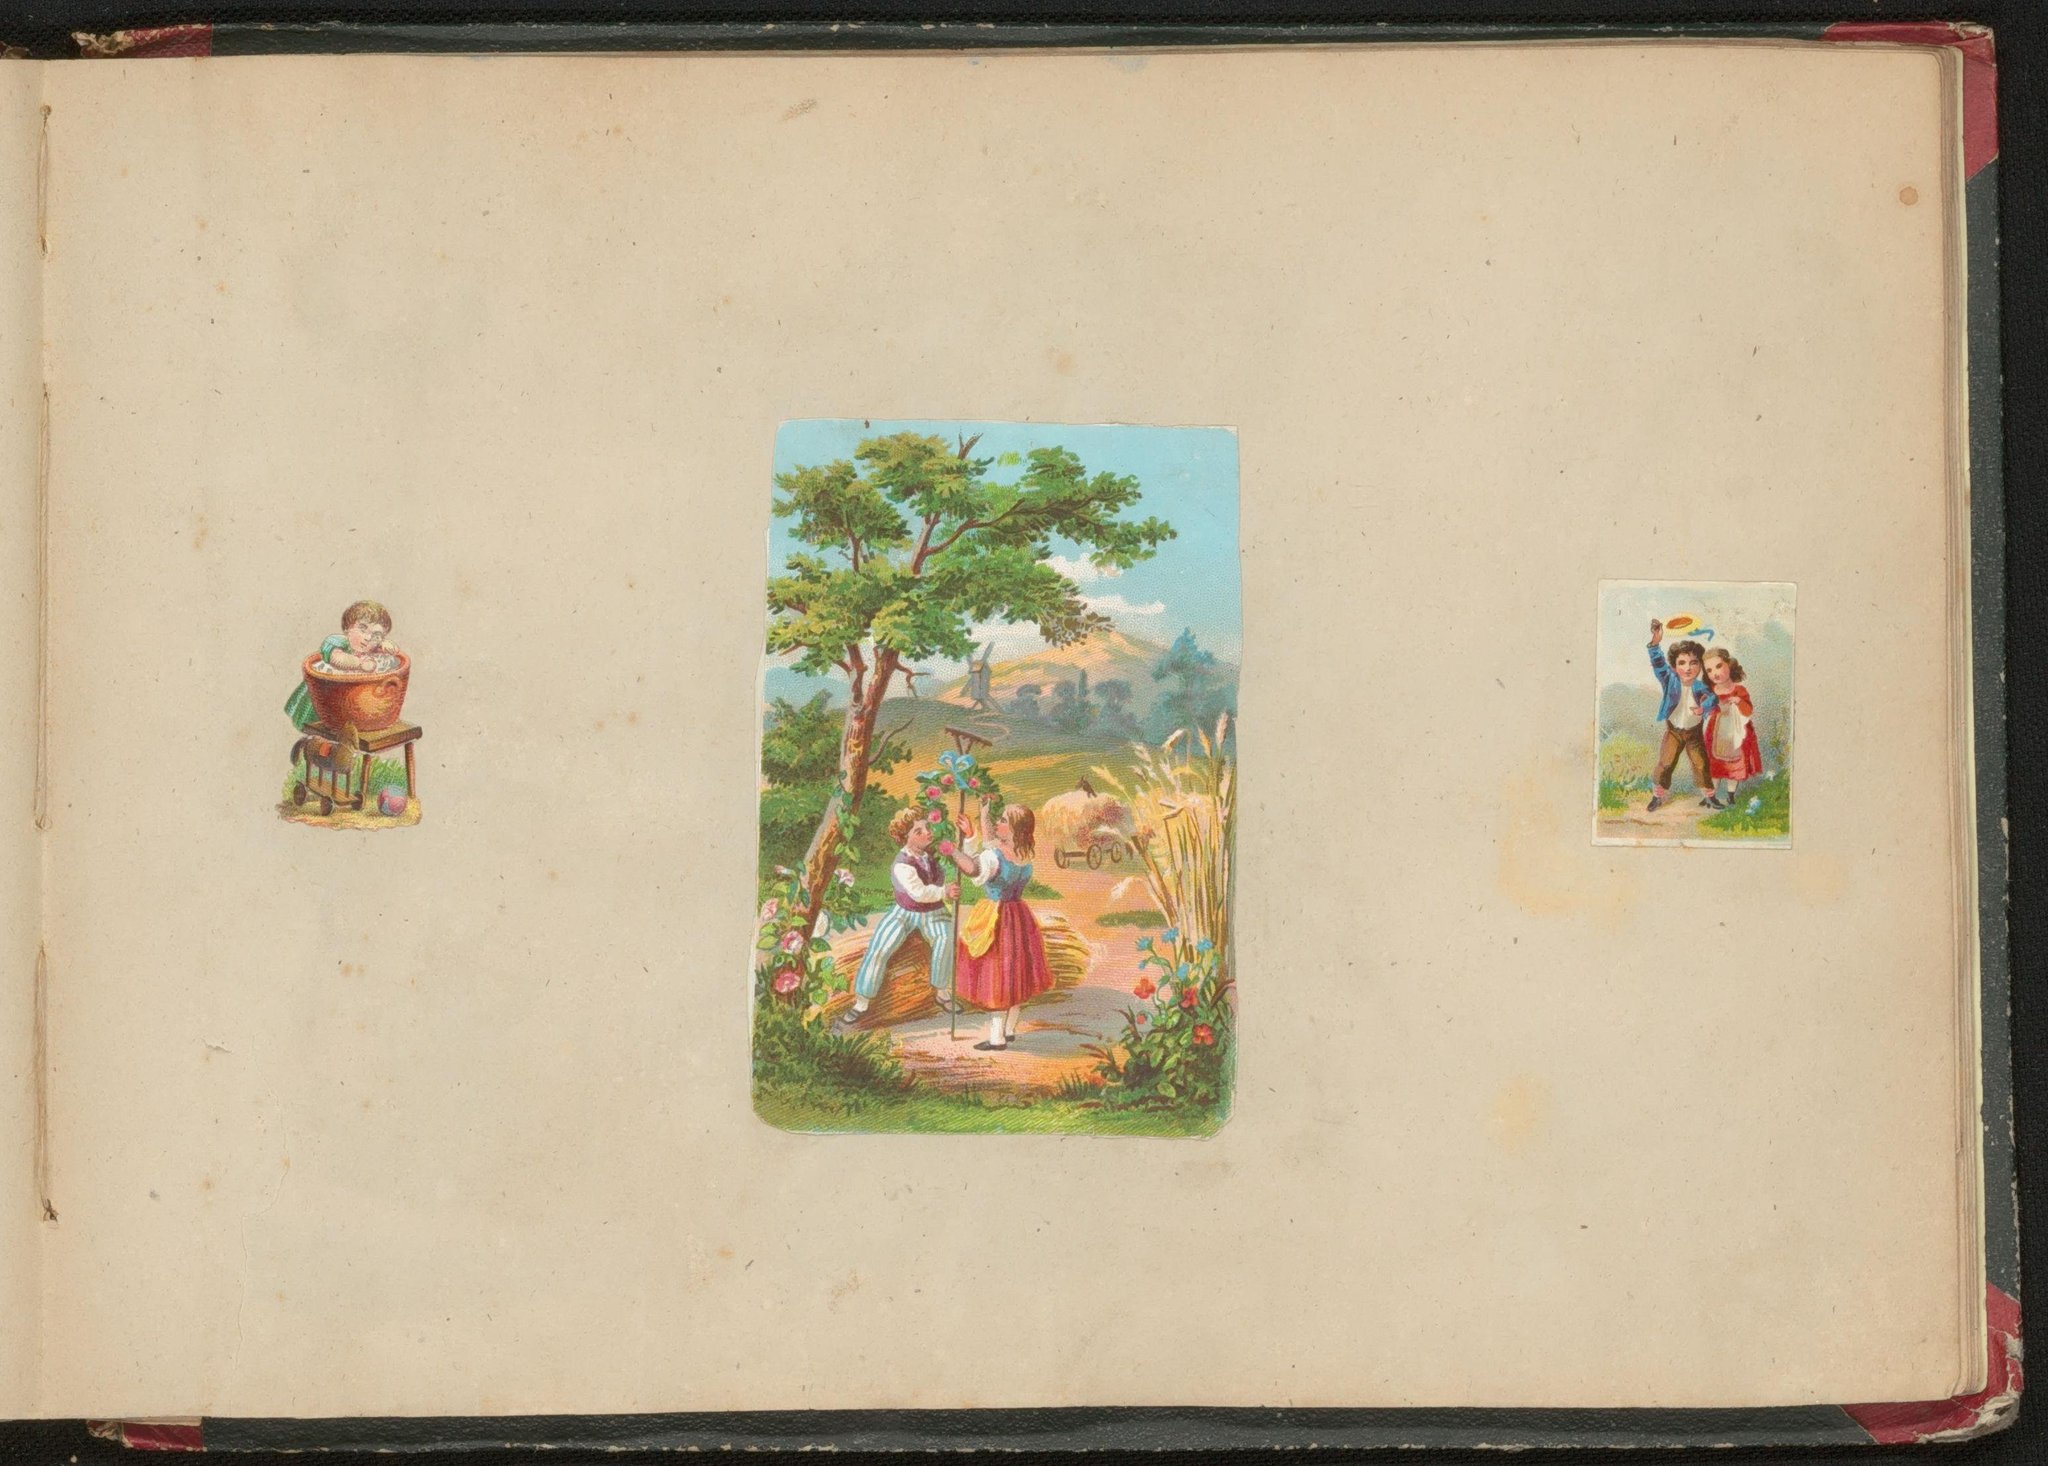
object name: album leaf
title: Albumblad met 3 plakplaatjes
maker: Anonymous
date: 1880-1910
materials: paper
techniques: chromolithography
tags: children's games and plays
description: Albumblad met 3 plakplaatjes van kinderen. Onderdeel van het plakboek met 38 bladen gevuld met plakplaatjes, poesieplaatjes en uitgeknipte en ingeplakte fragmenten van prenten. Onderwerpsrubrieken binnen de Atlas Zeden en Gewoonten: Schoone kunsten, Varia.